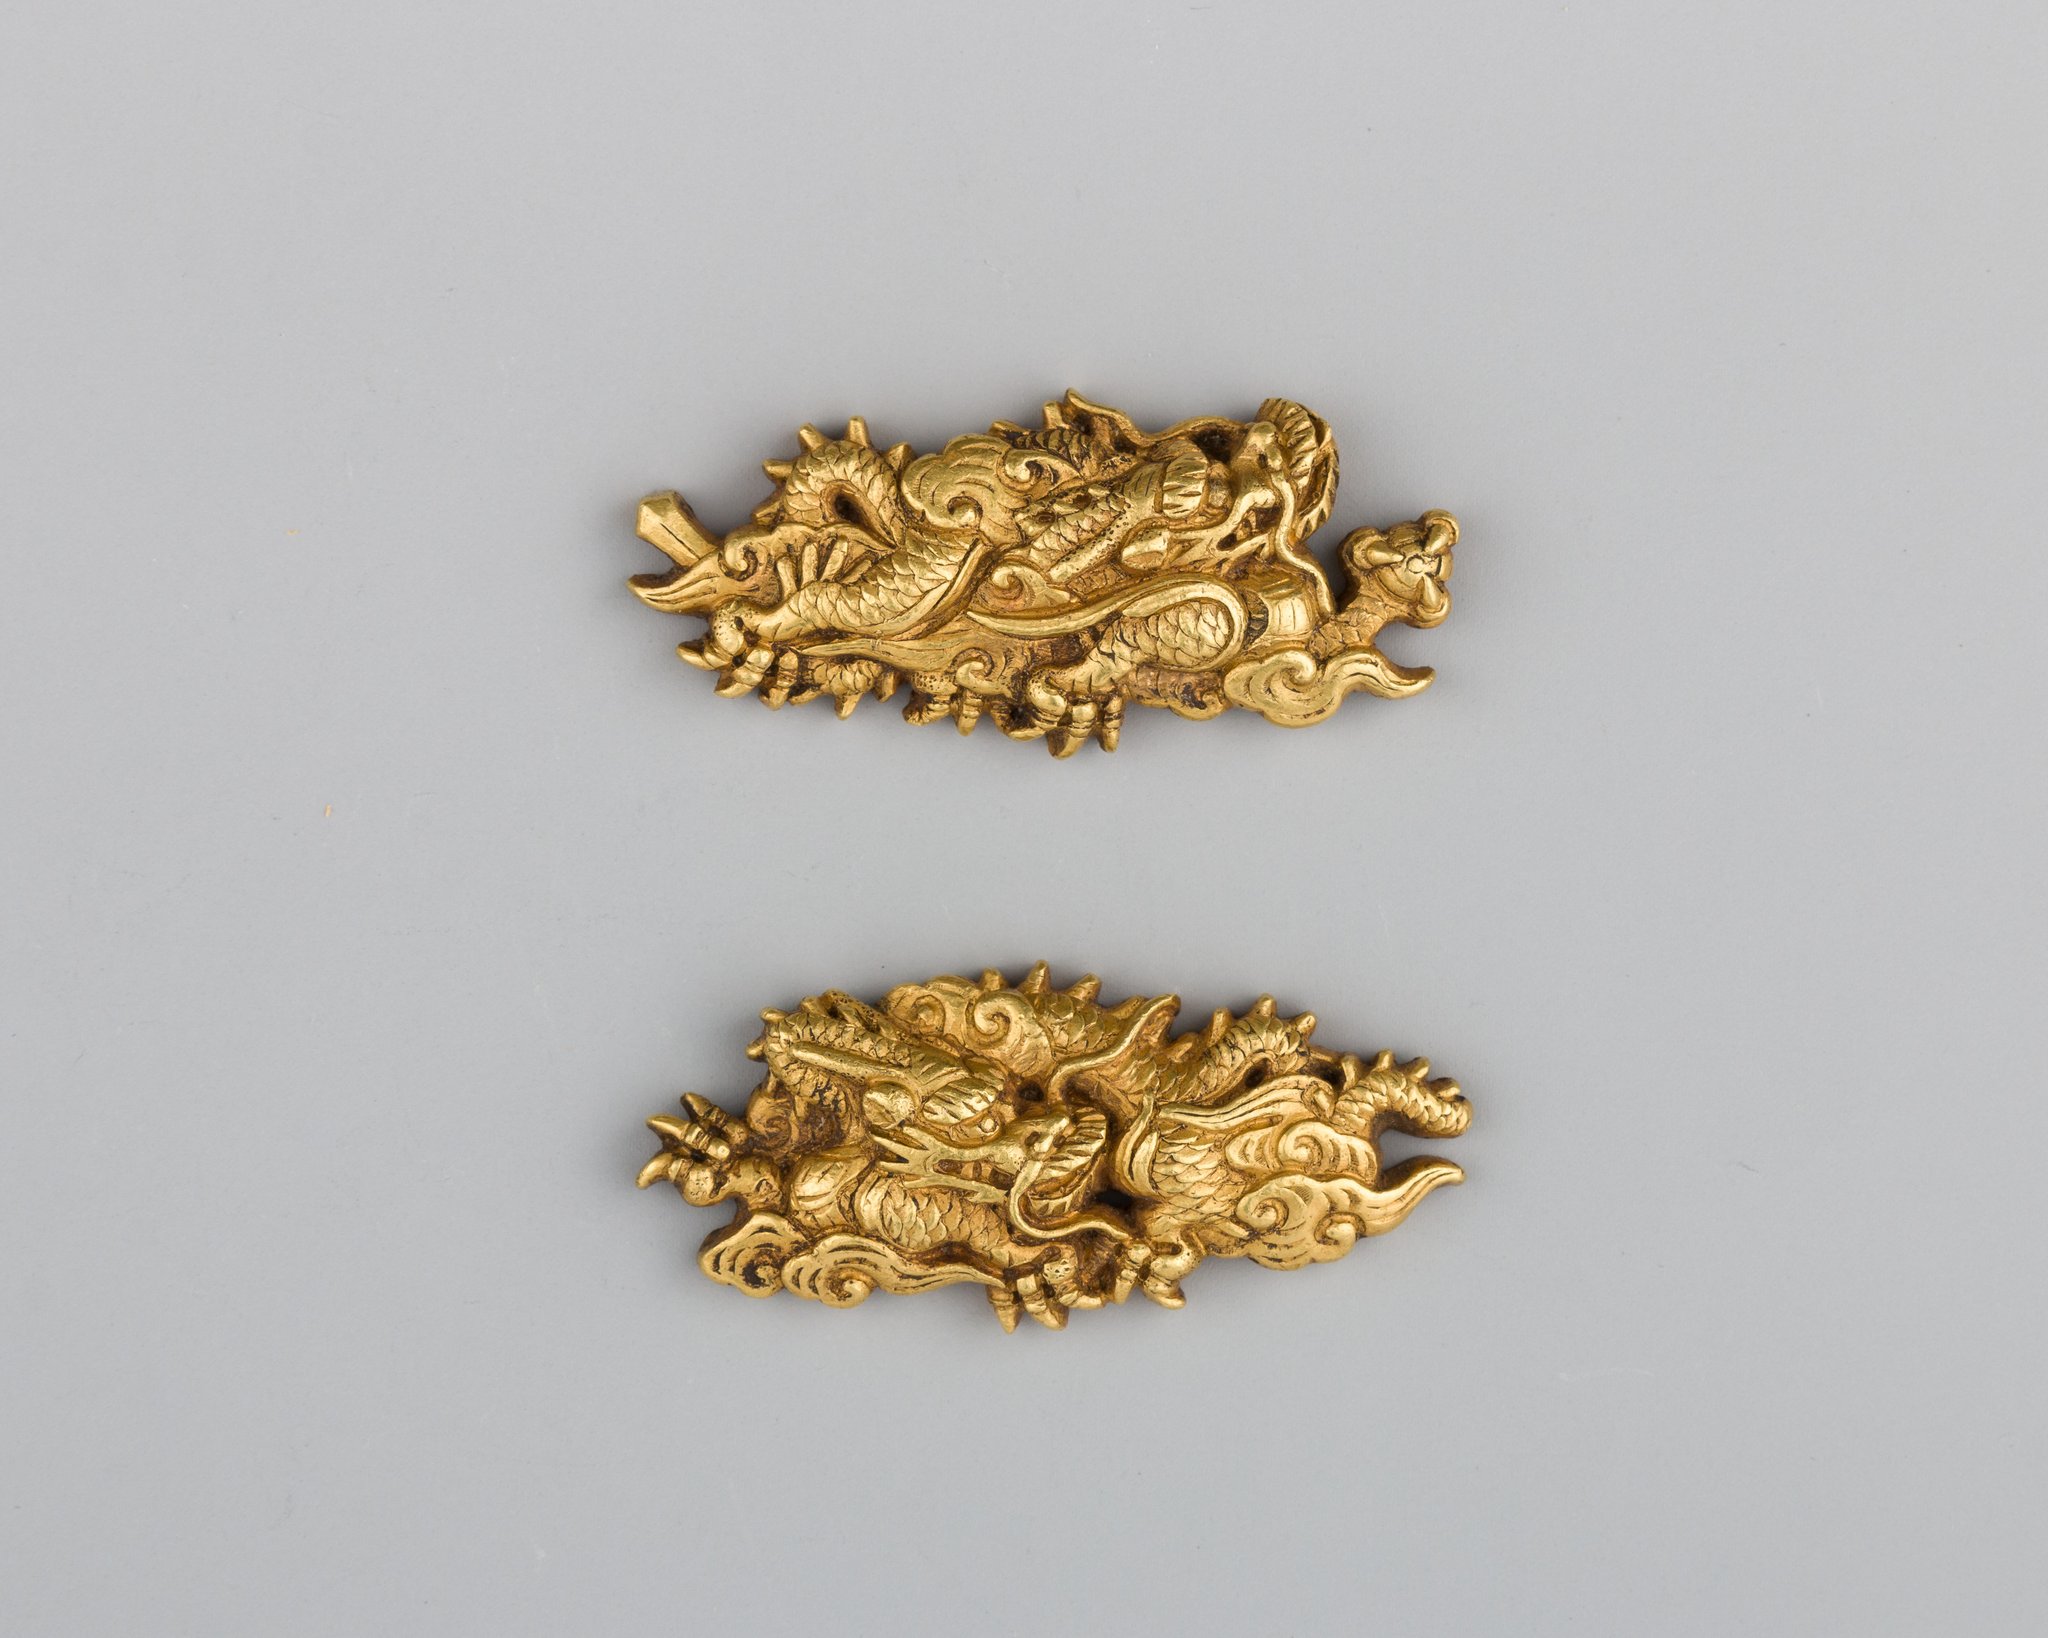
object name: pair of sword grip ornament menuki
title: Pair of Sword-Grip Ornaments (Menuki)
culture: japanese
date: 1601-1633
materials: gold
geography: japan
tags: dragons